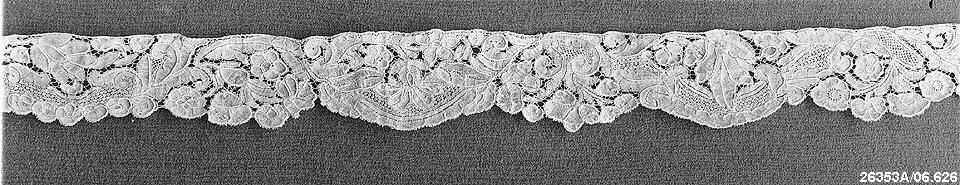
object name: strip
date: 1700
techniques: lace